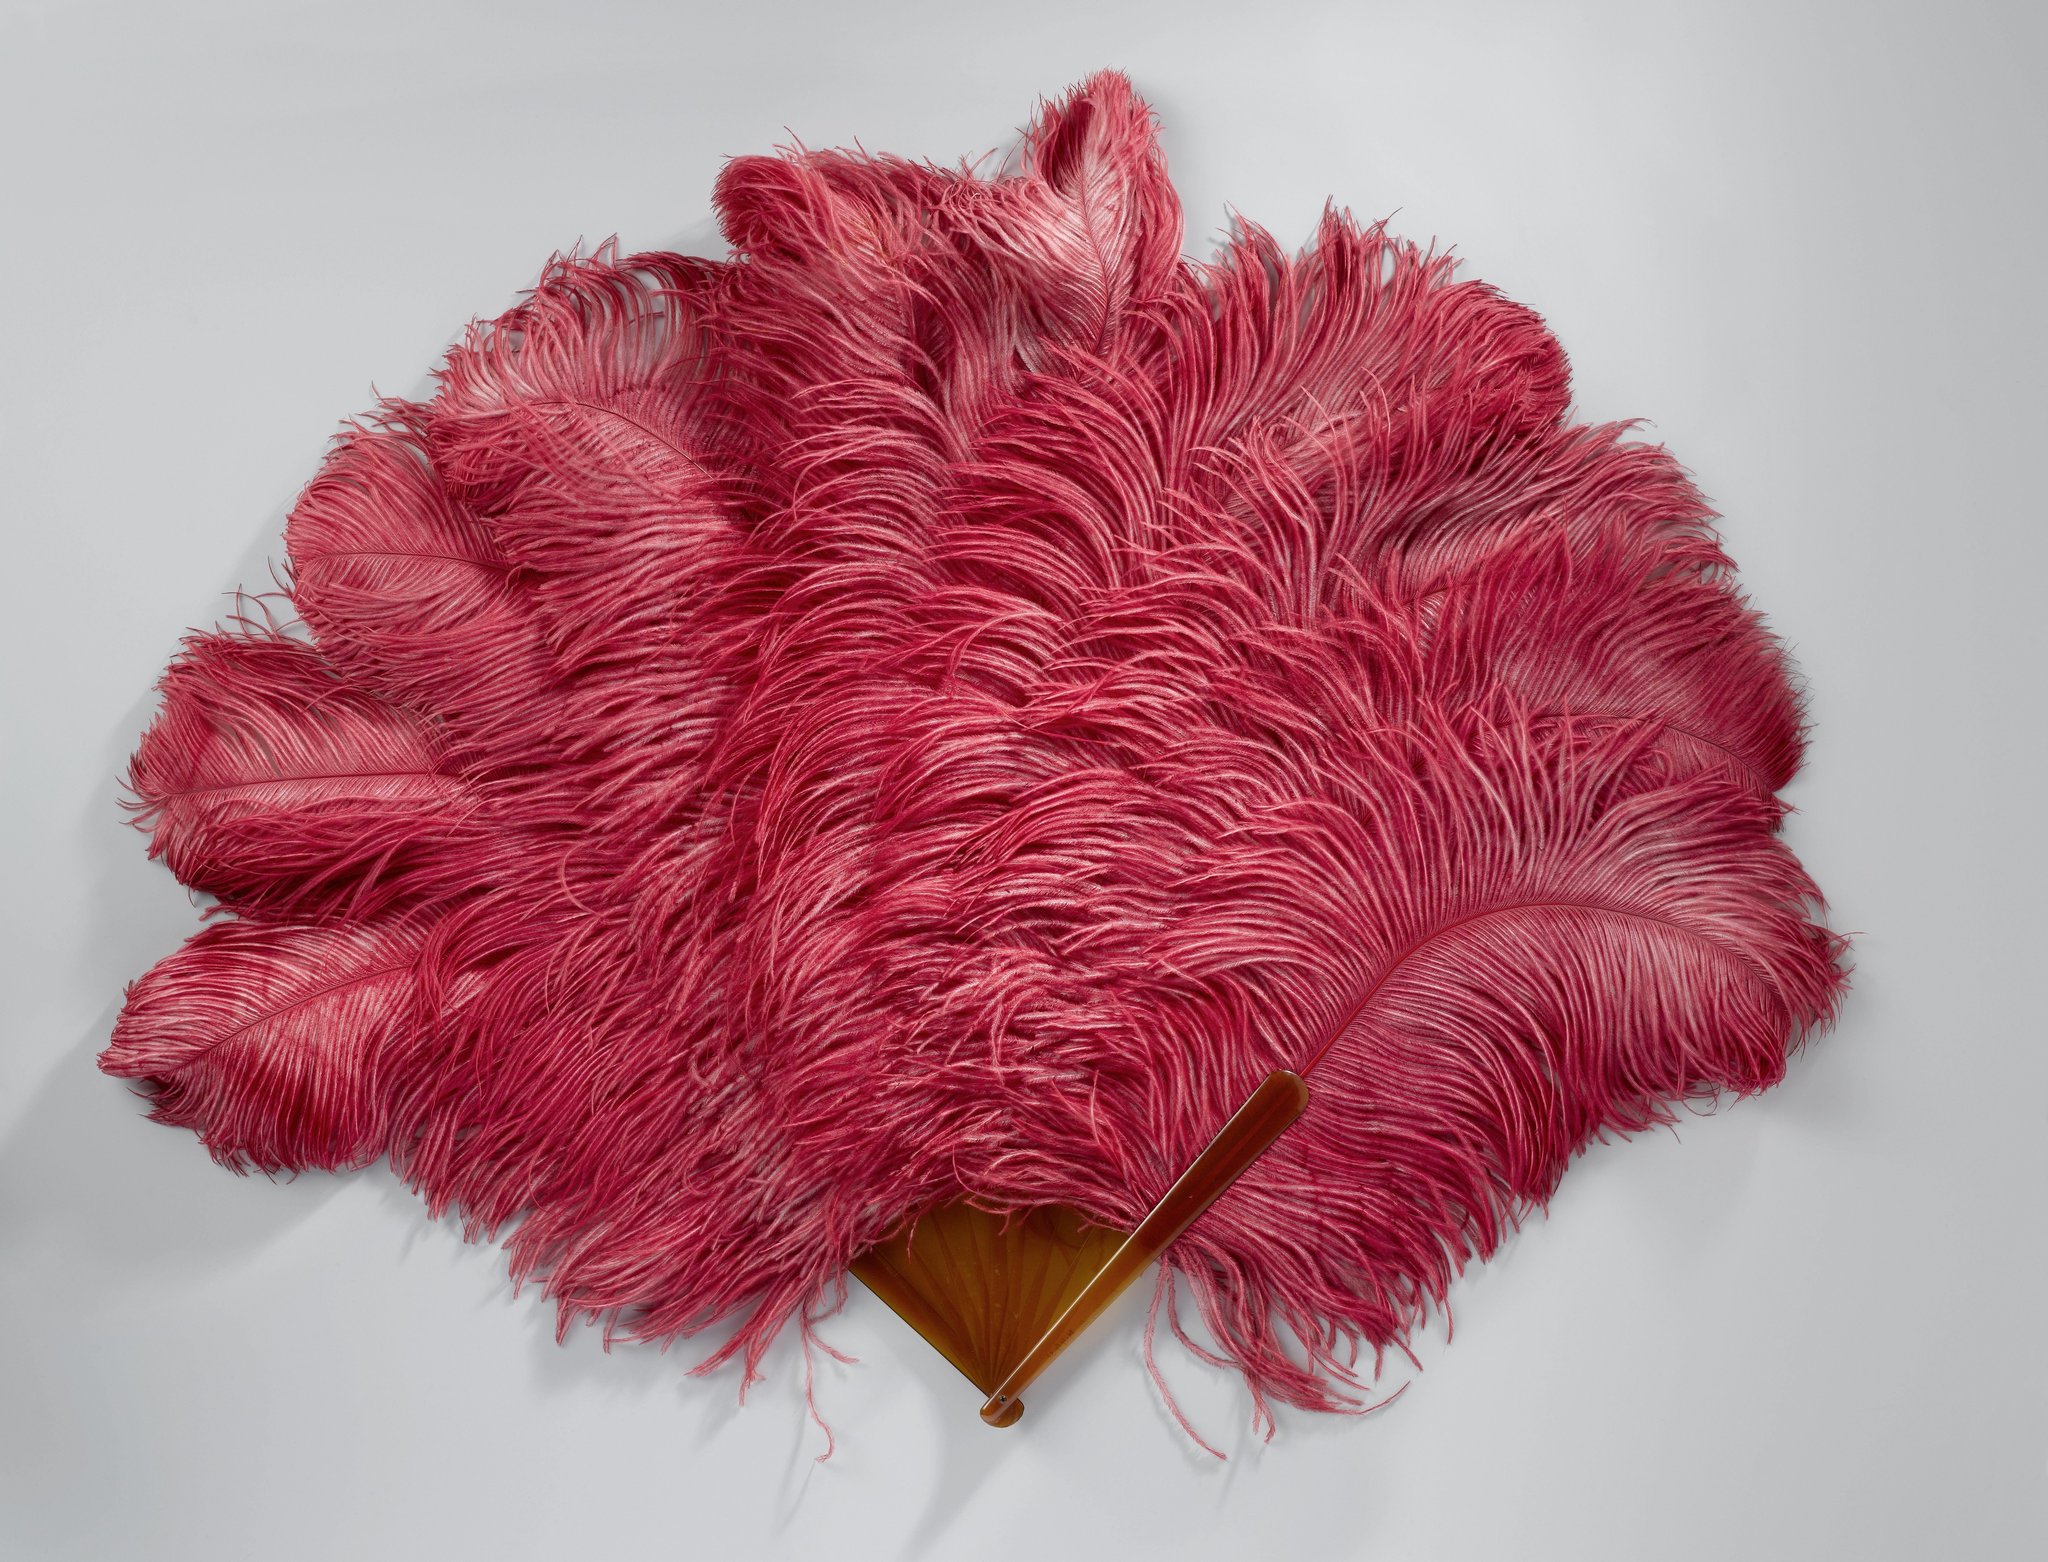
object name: vouwwaaier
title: Vouwwaaier met felroze struisveren op een montuur van onversierd van kunststof met schildpadmotief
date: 1900-1925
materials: plastic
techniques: painting, pressing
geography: paris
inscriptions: company name: ‘Duvelleroy Paris’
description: Vouwwaaier met felroze struisveren op een montuur van 10 aaneengesloten benen van onversierd van kunststof met schildpadmotief.